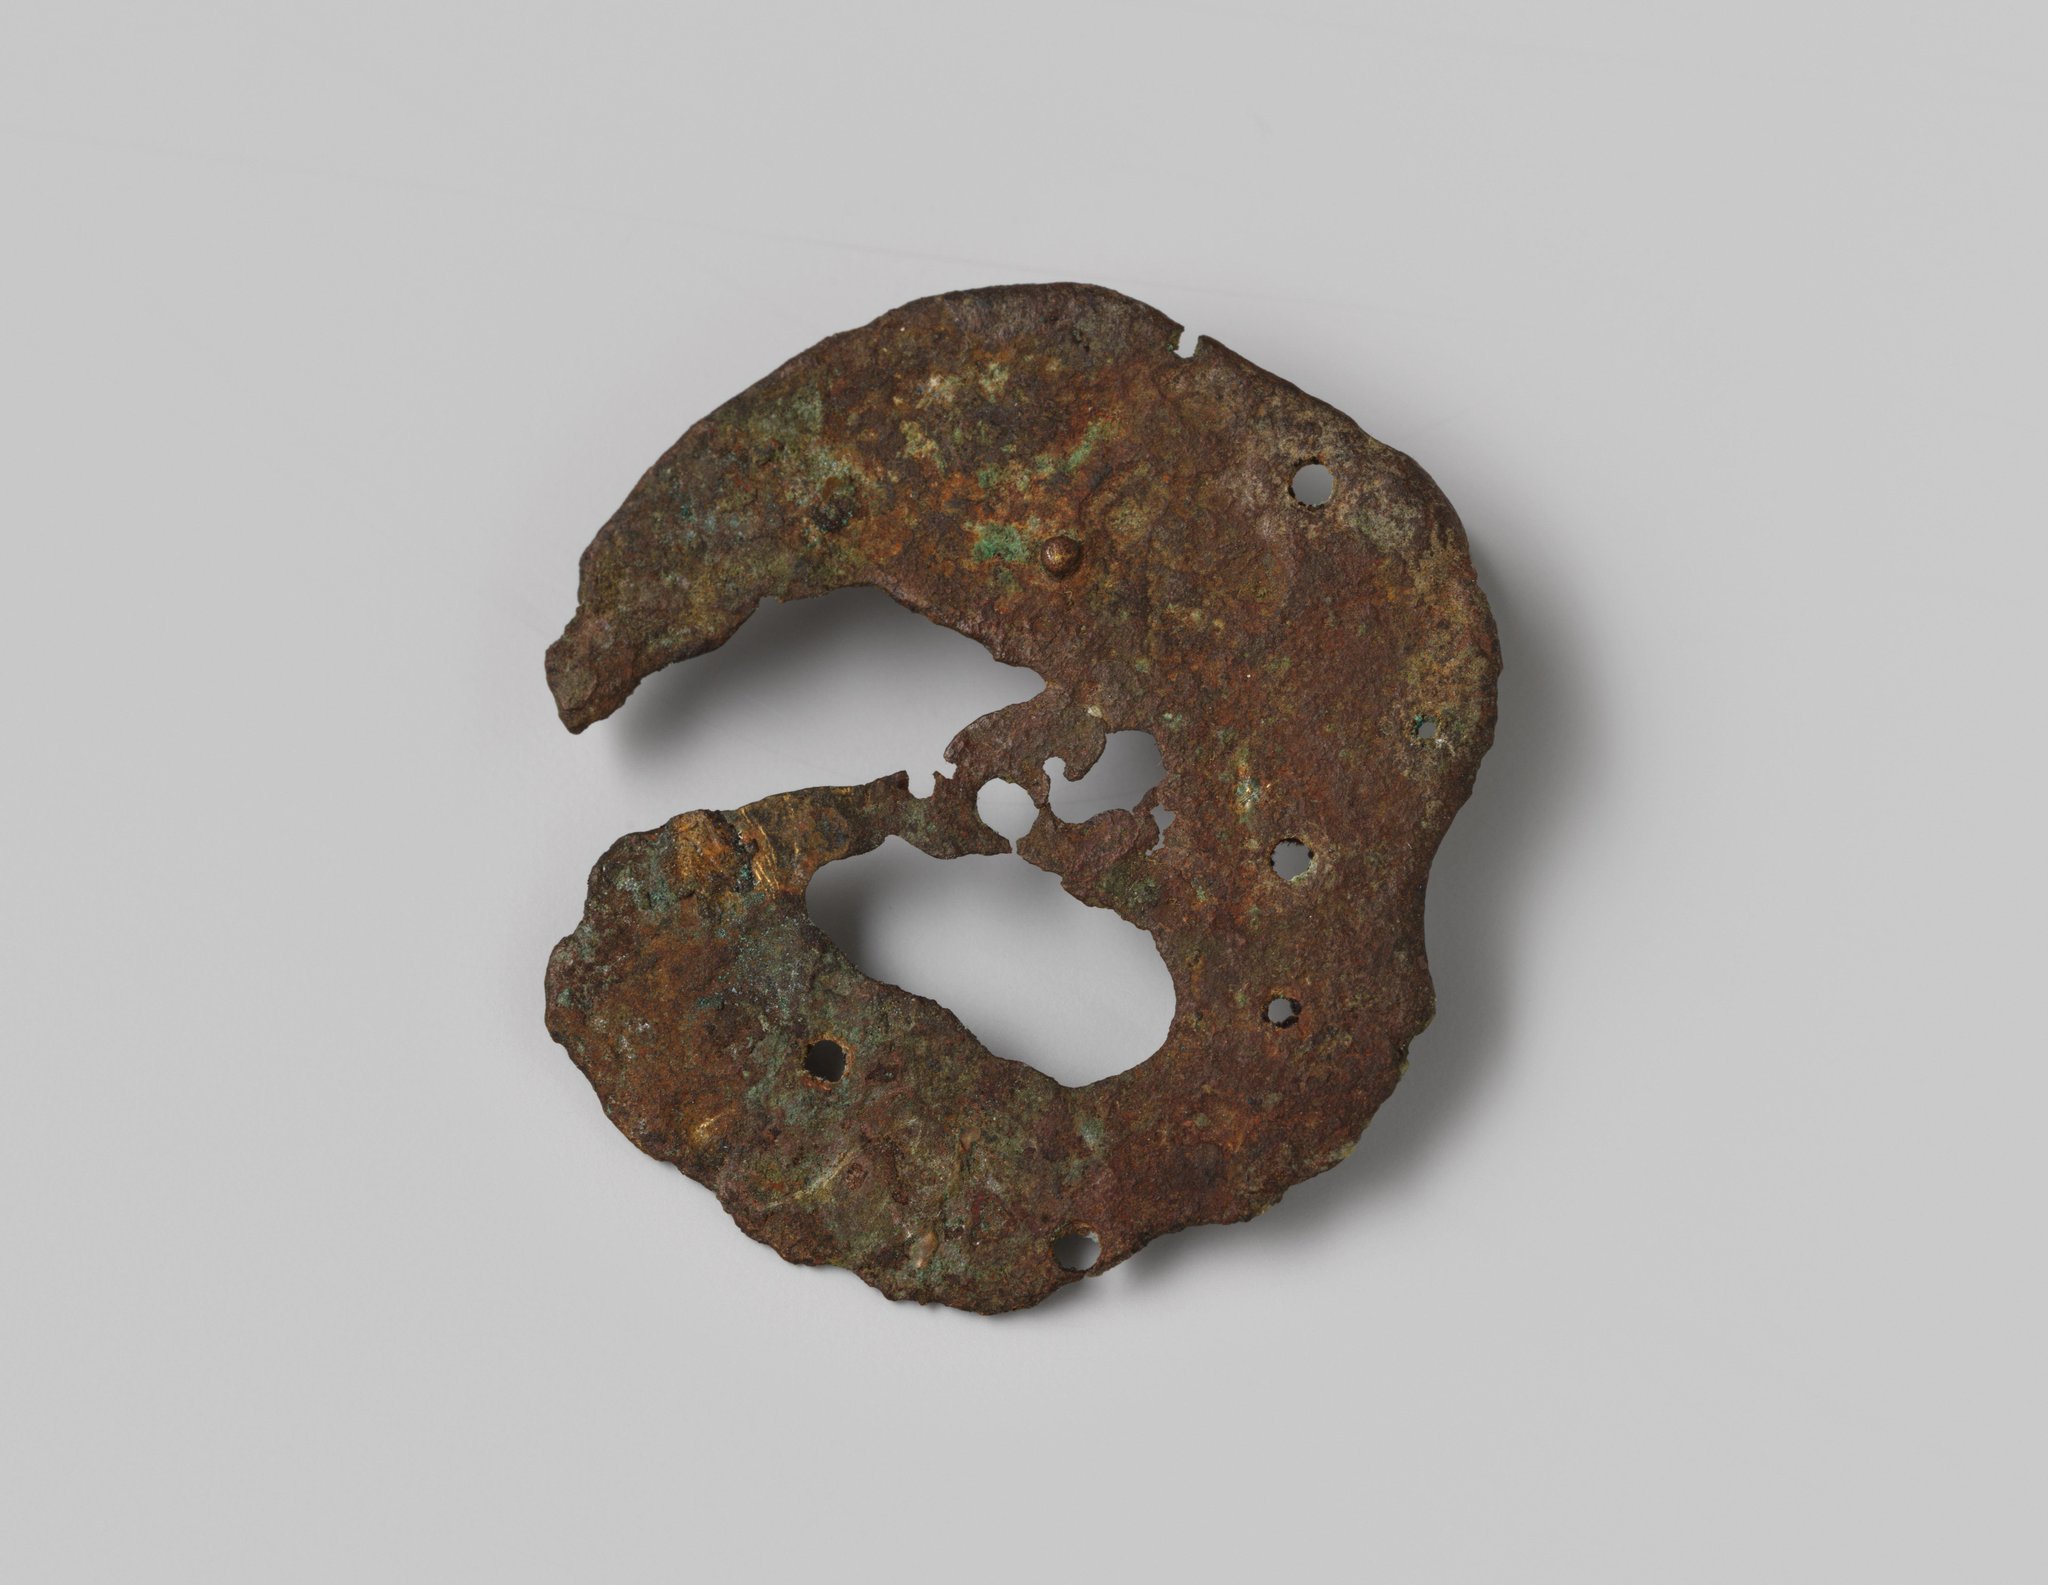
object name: fragment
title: Fragment van koper uit het wrak van de Oost-Indiëvaarder Hollandia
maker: Anonymous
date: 1700-1743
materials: copper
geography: netherlands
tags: verenigde oostindische compagnie, hollandia (schip), annet